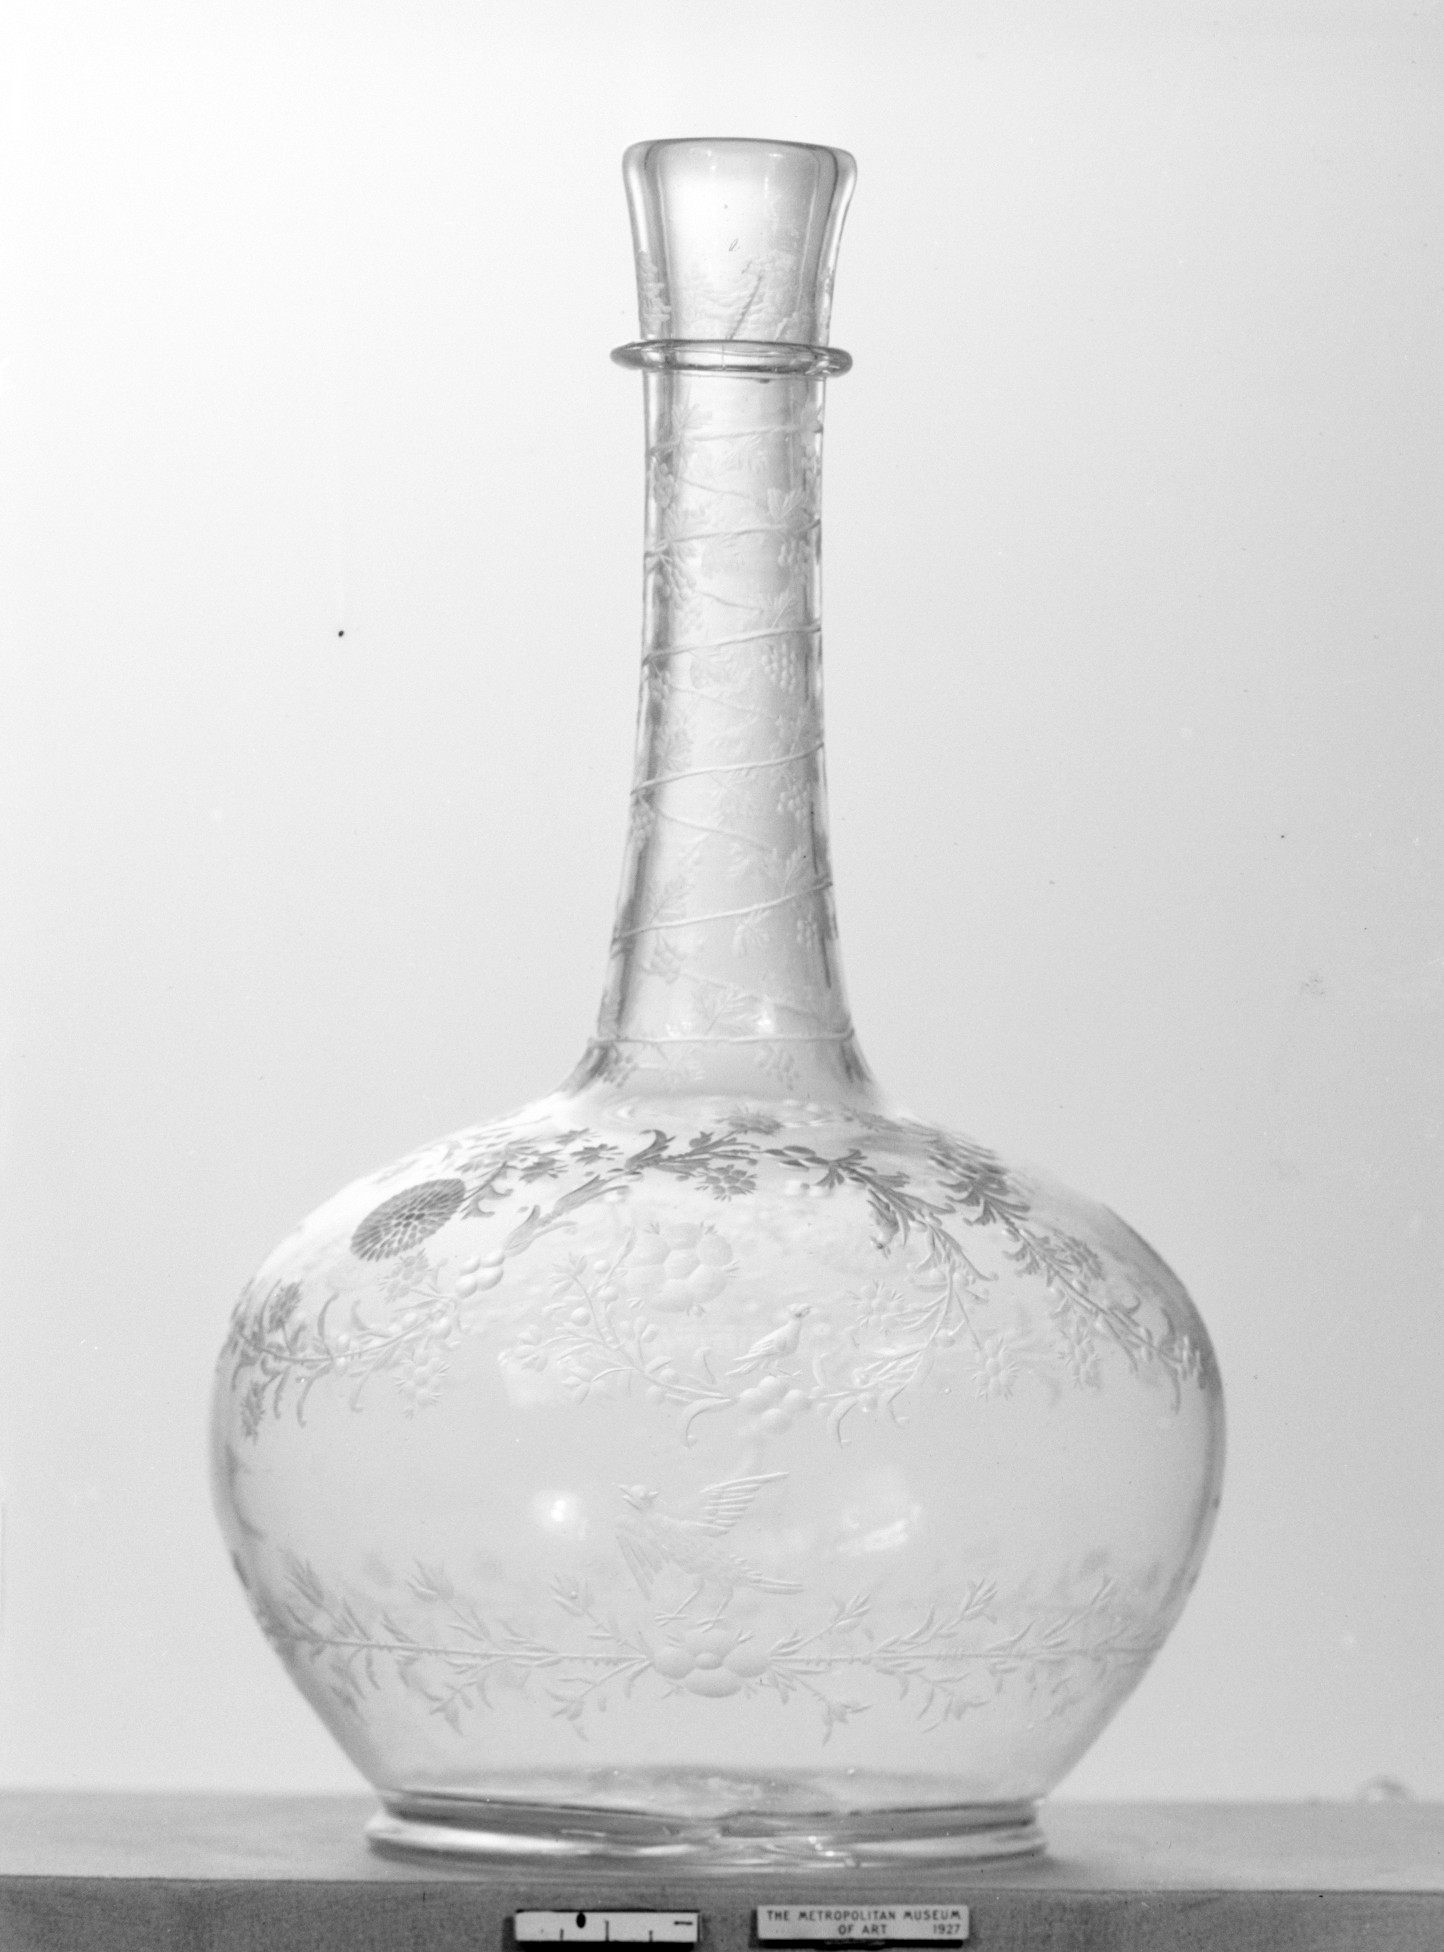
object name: bottle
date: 1710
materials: glass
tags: birds,flowers